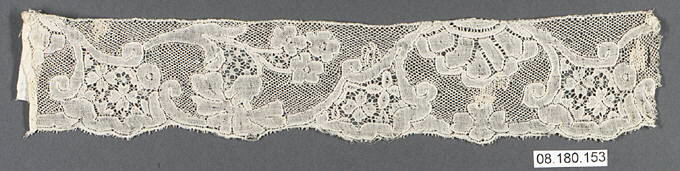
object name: piece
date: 1701-1800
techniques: lace